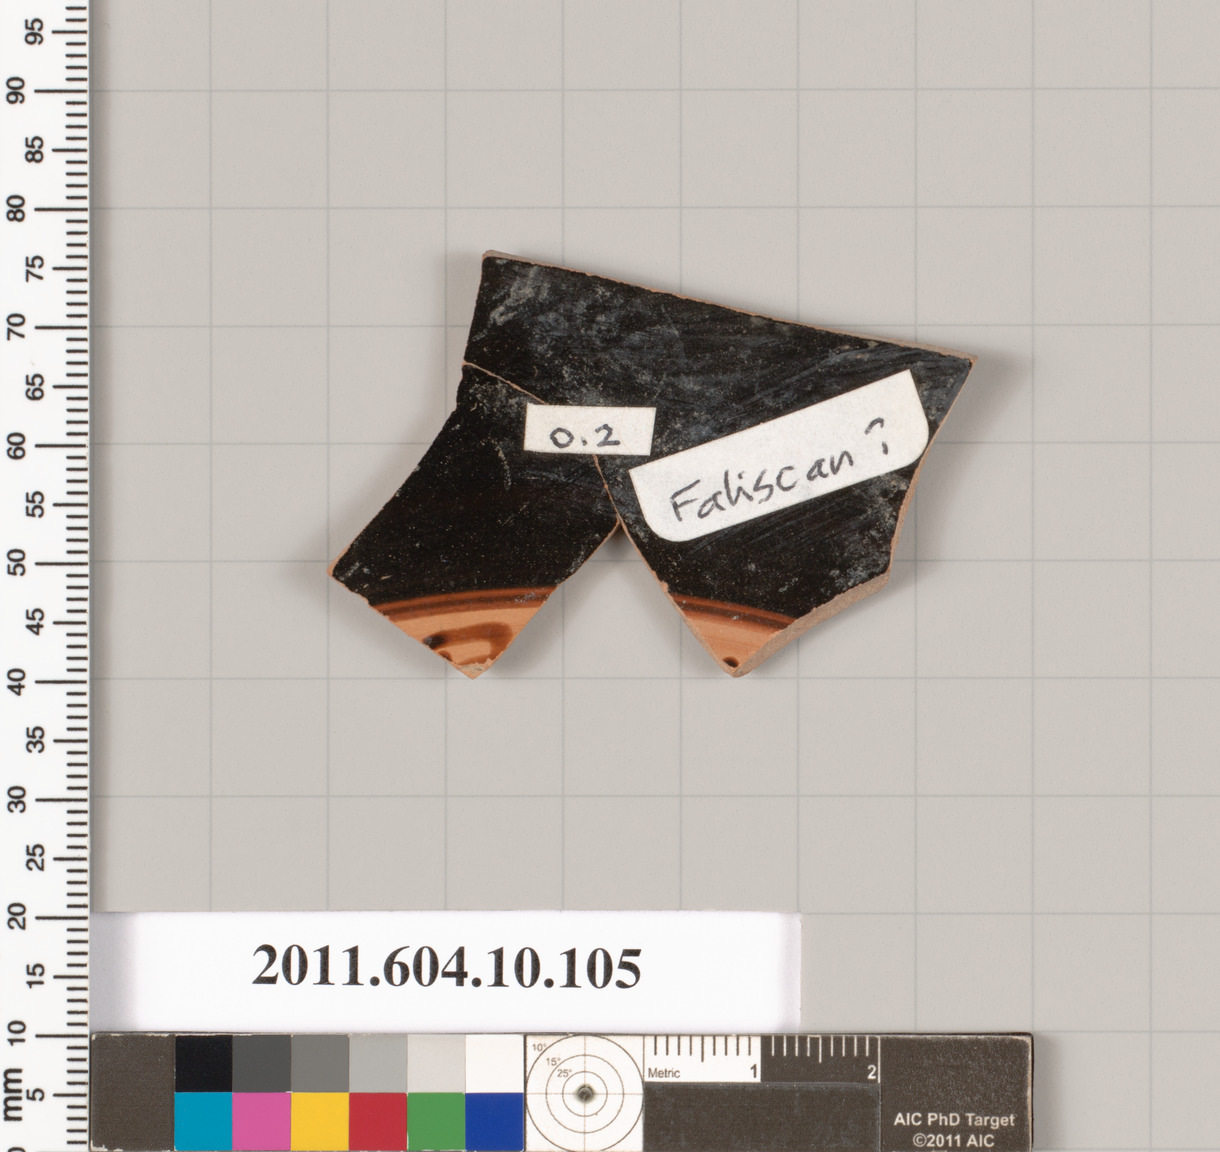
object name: kylix fragment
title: Terracotta fragment of a kylix (drinking cup)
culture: etruscan or faliscan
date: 400-301 BCE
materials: terracotta